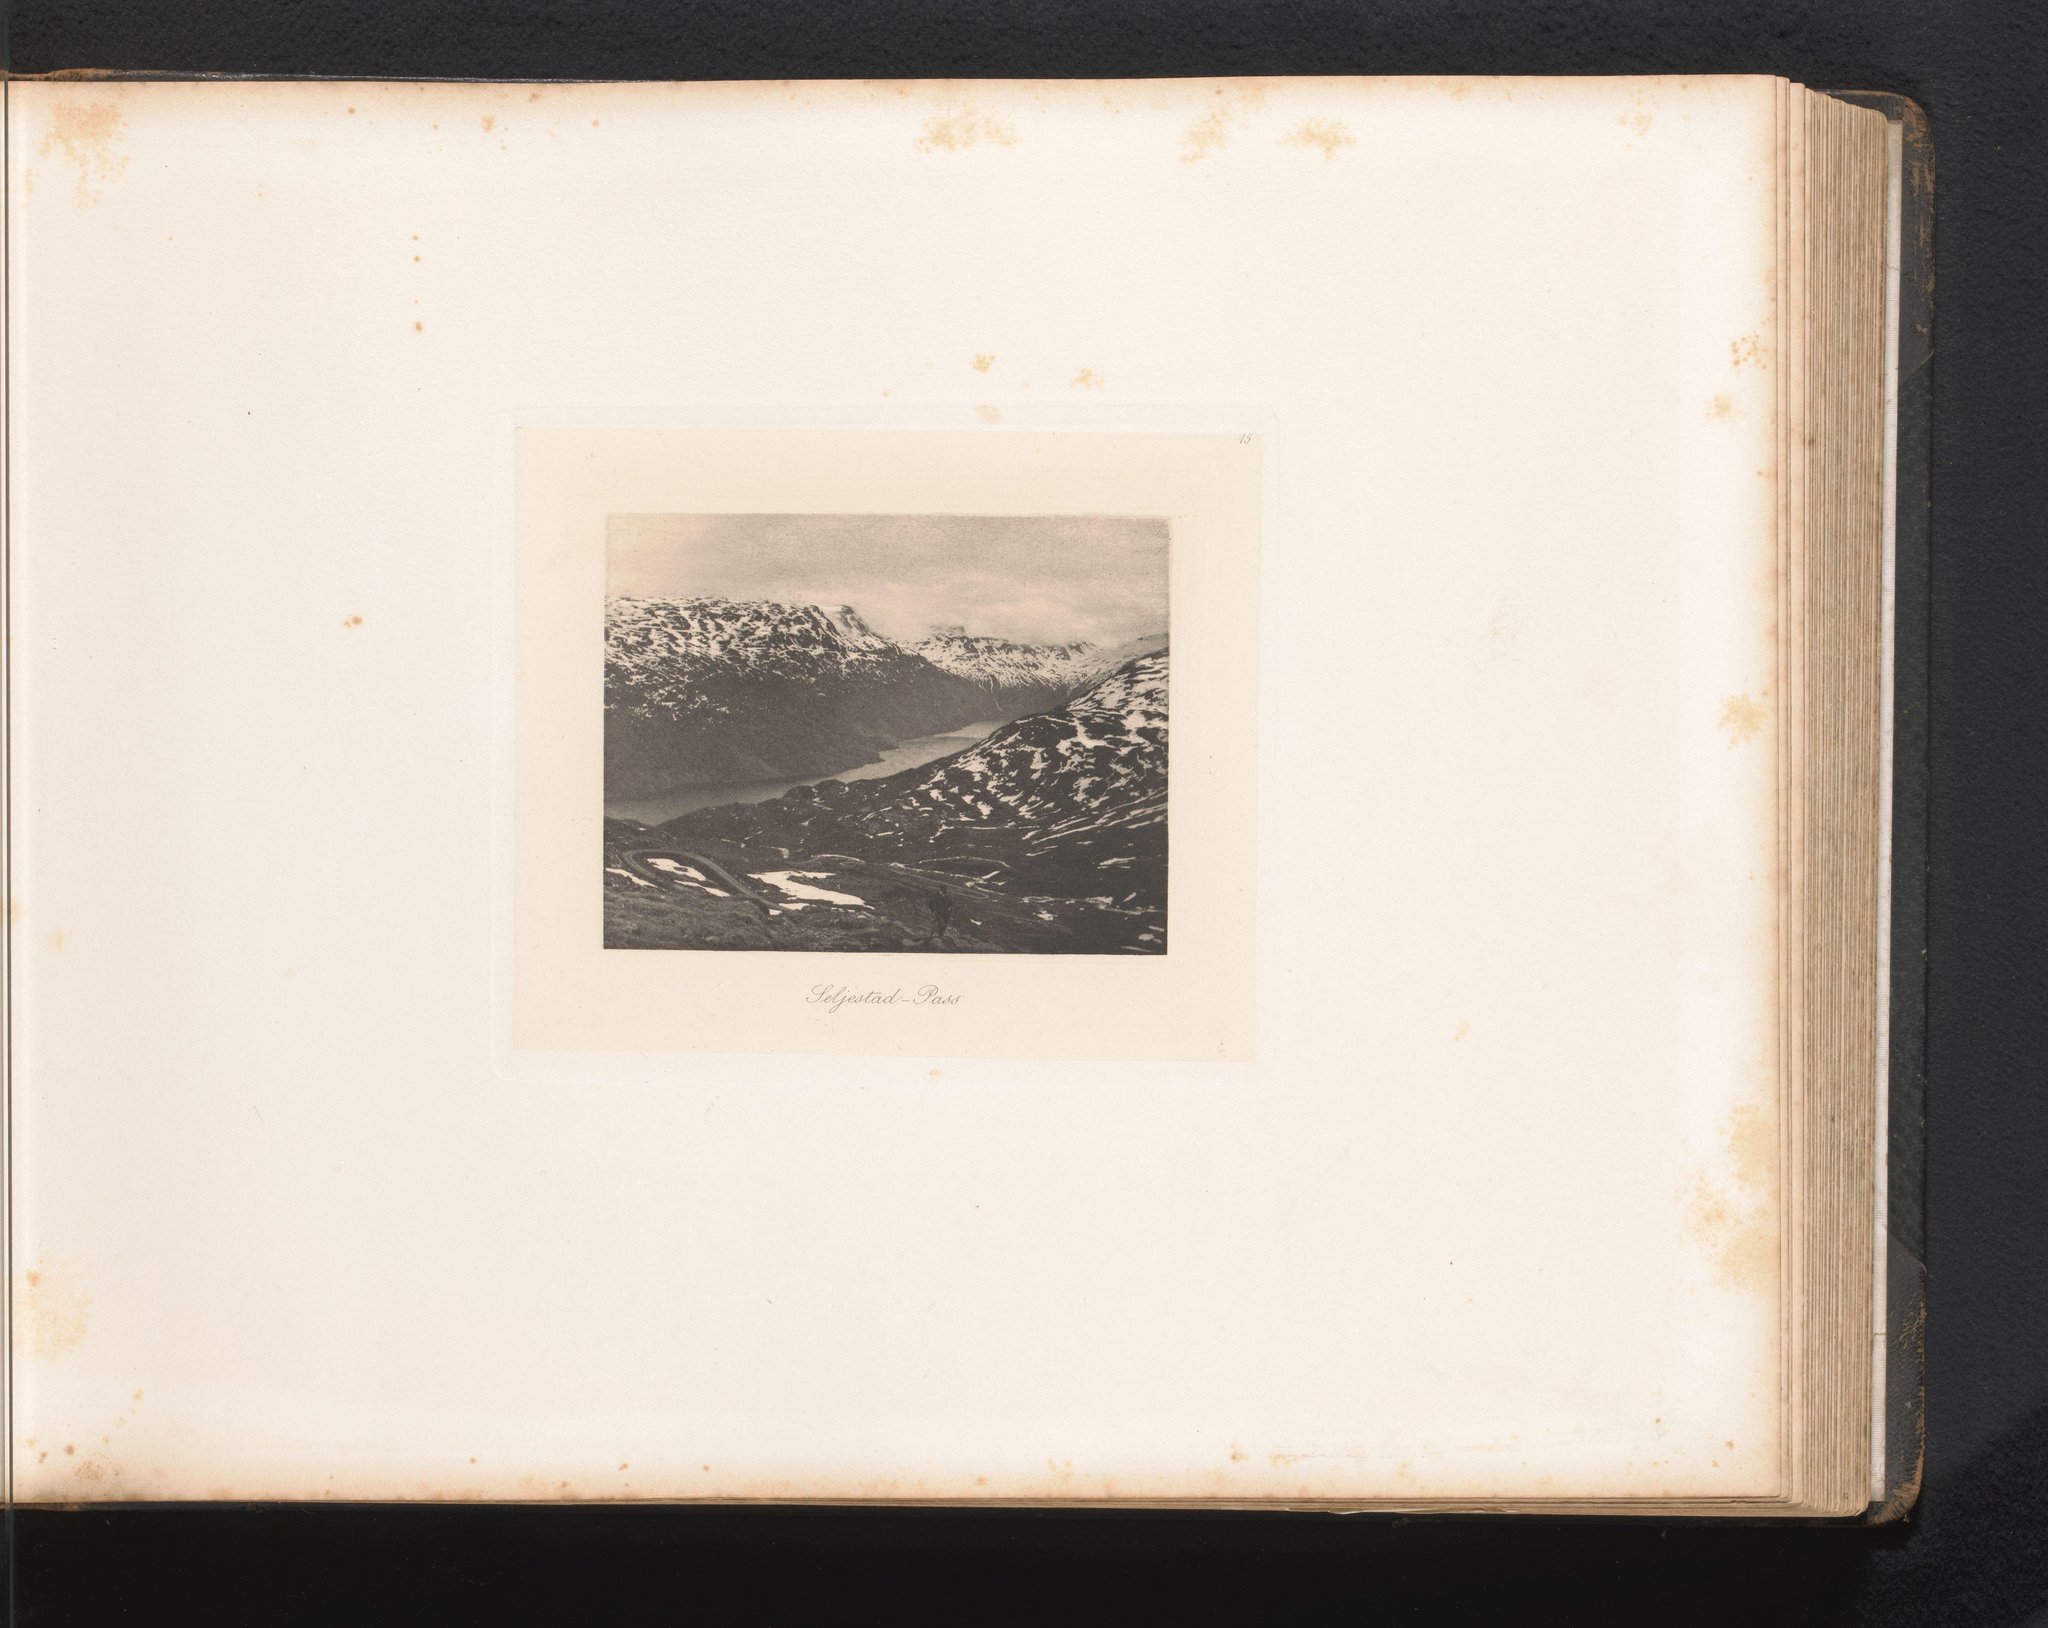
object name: page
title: Seljestad-Pass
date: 1888-1893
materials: paper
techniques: photograph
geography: vienna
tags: fjord, sea loch, mountain-range, snow peaks (+ landscape with figures, staffage)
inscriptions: number: ‘15’